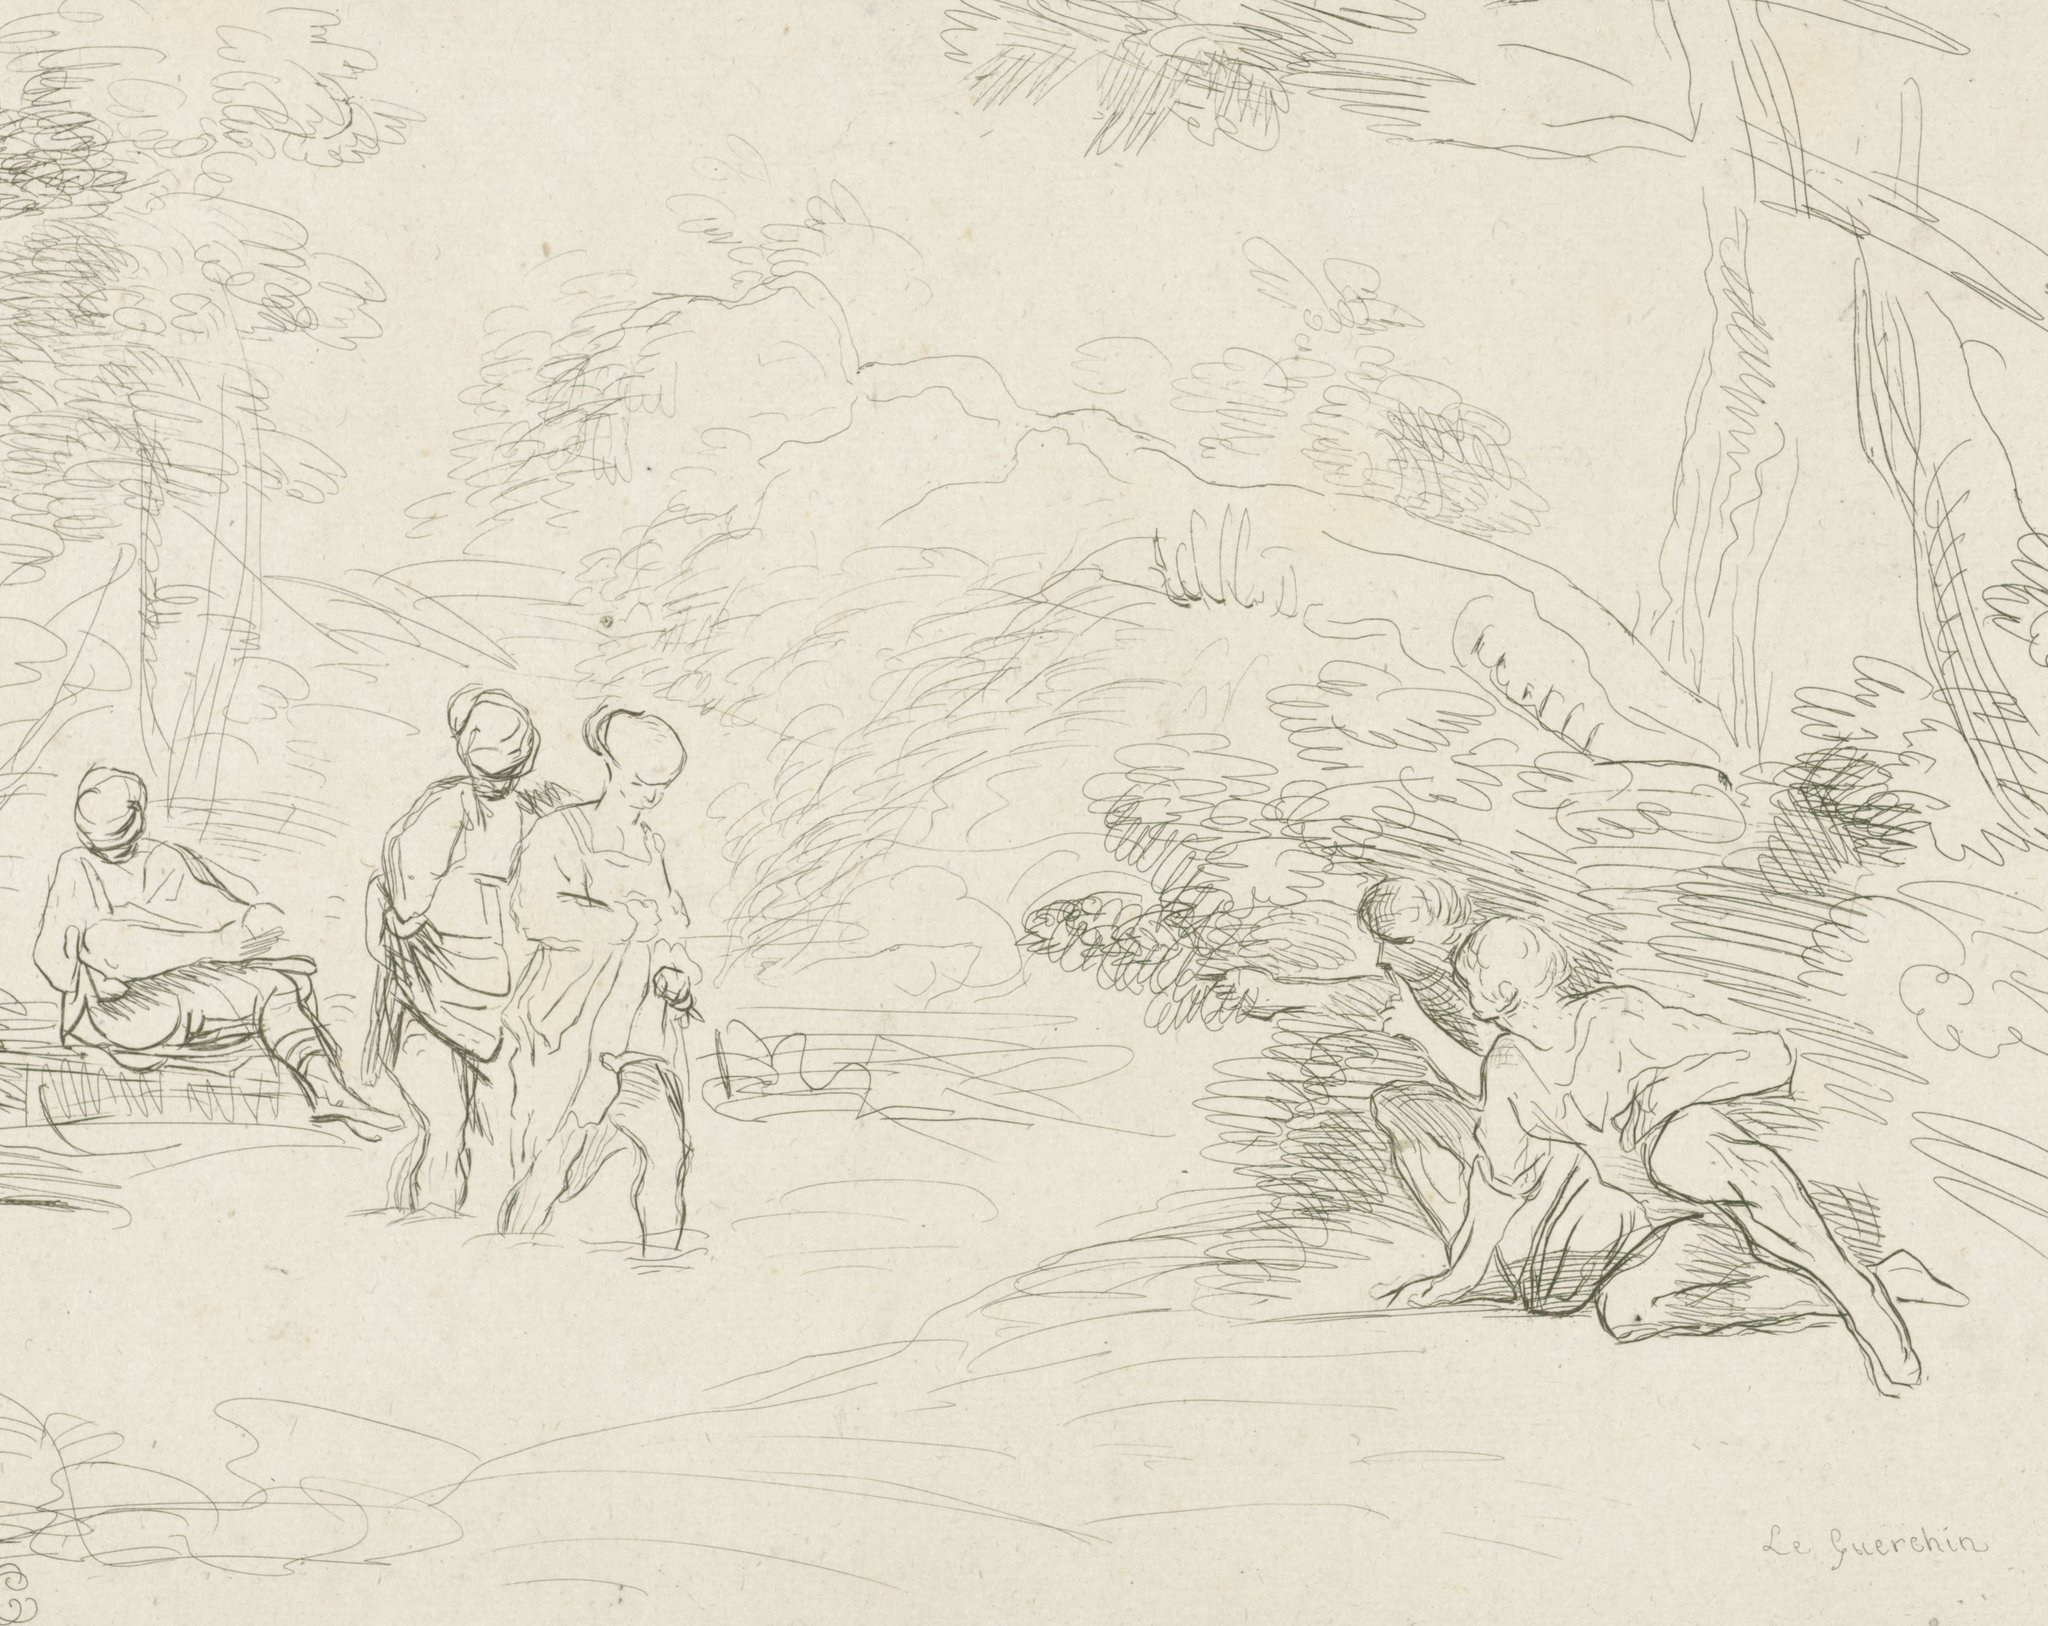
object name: print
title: Badende vrouwen door mannen bespied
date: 1774-1792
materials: paper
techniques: etching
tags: peeping, voyeur, washing and bathing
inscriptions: collector's mark: Lugt 2228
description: Drie badende vrouwen worden bespied door twee mannen in het struikgewas.